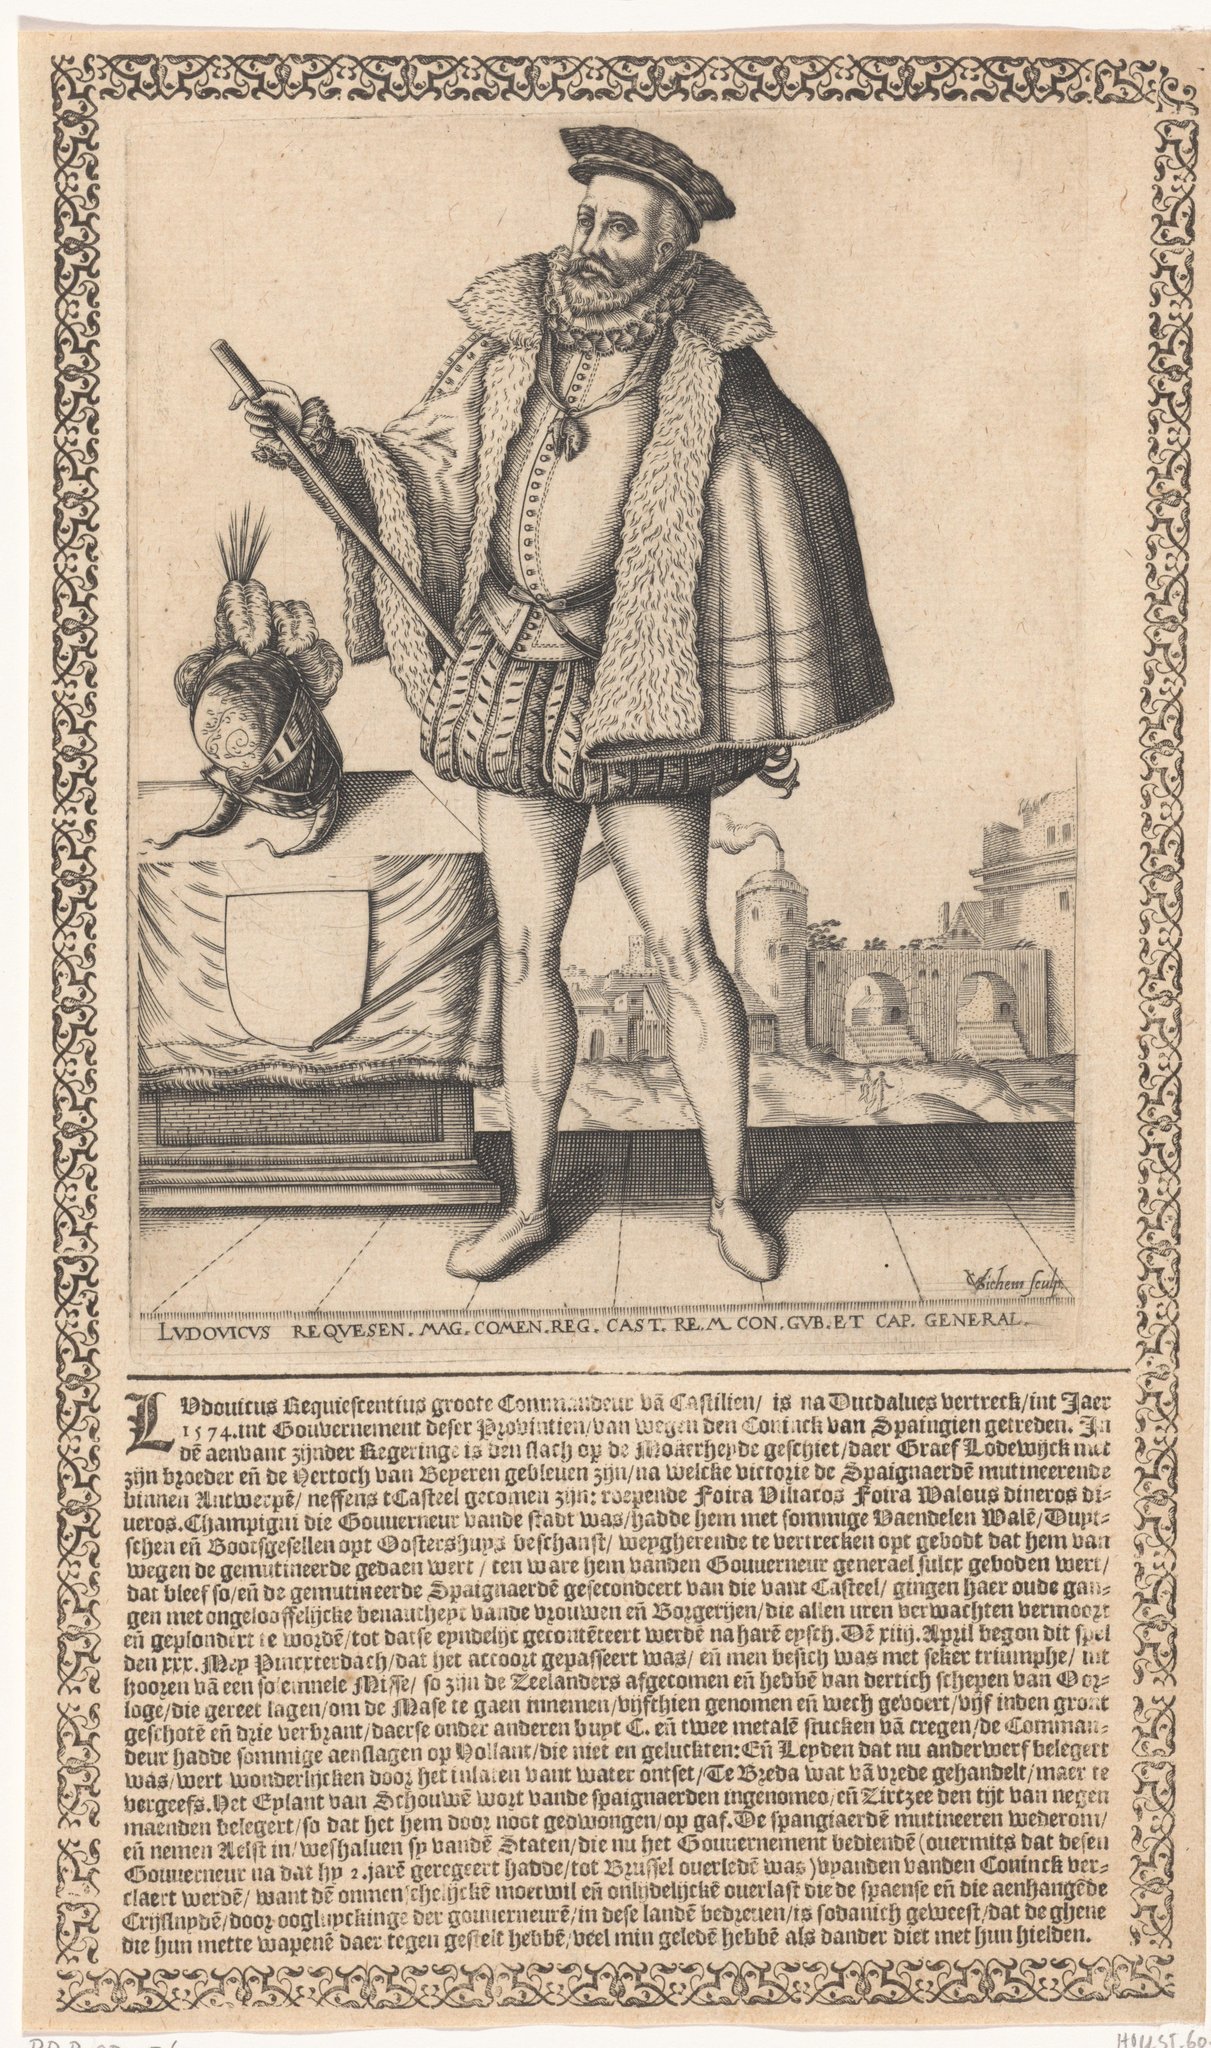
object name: print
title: Portret van Don Luis de Requesens y Zunega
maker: christoffel van sichem (i)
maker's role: print maker, publisher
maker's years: 1546-1624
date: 1611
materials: paper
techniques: engraving, etching, letterpress printing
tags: brussels, mayor, luis de zúñiga y requesens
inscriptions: collector's mark: Lugt 2228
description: Portret van Don Luis de Requesens, gouverneur-generaal van de Nederlanden. Hij draagt een met bont gevoerde korte mantel en houdt een commandostaf in de hand. Hij staat naast een met een kleed bedekt voetstuk, waarop de helm van zijn harnas ligt. De ruimte voor zijn wapenschild is blanco gelaten. Op de achtergrond een stad. Onder de prent in het Latijn zijn naam en functie. Onder de prent Nederlandse tekst in boekdruk. Rondom een ornamentele omlijsting.